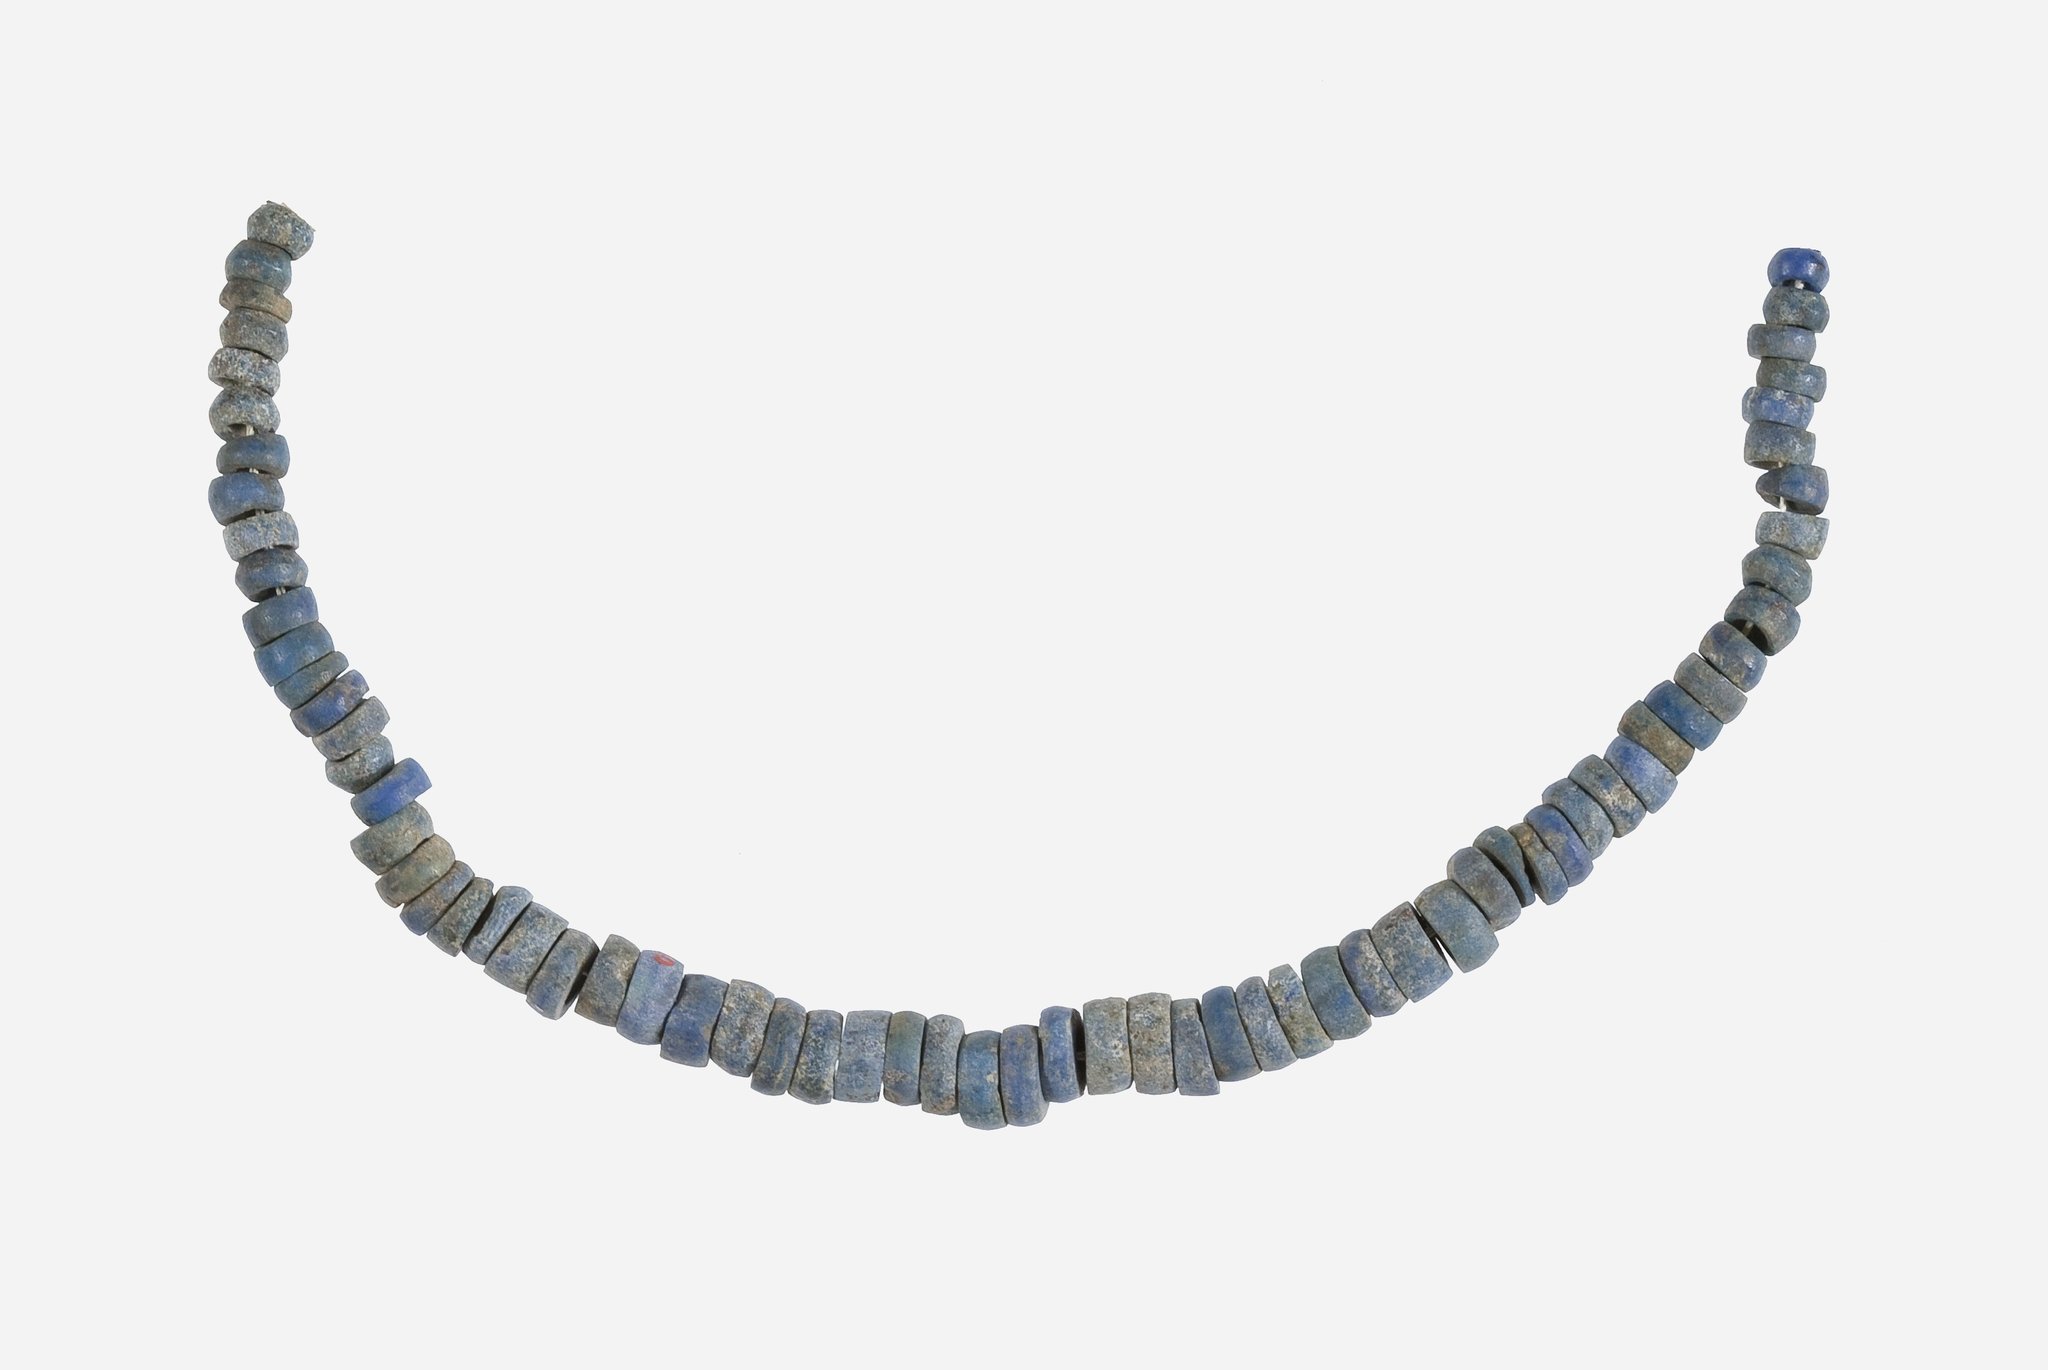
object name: bead, string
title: String of beads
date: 3300 BCE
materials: lapis lazuli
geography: egypt